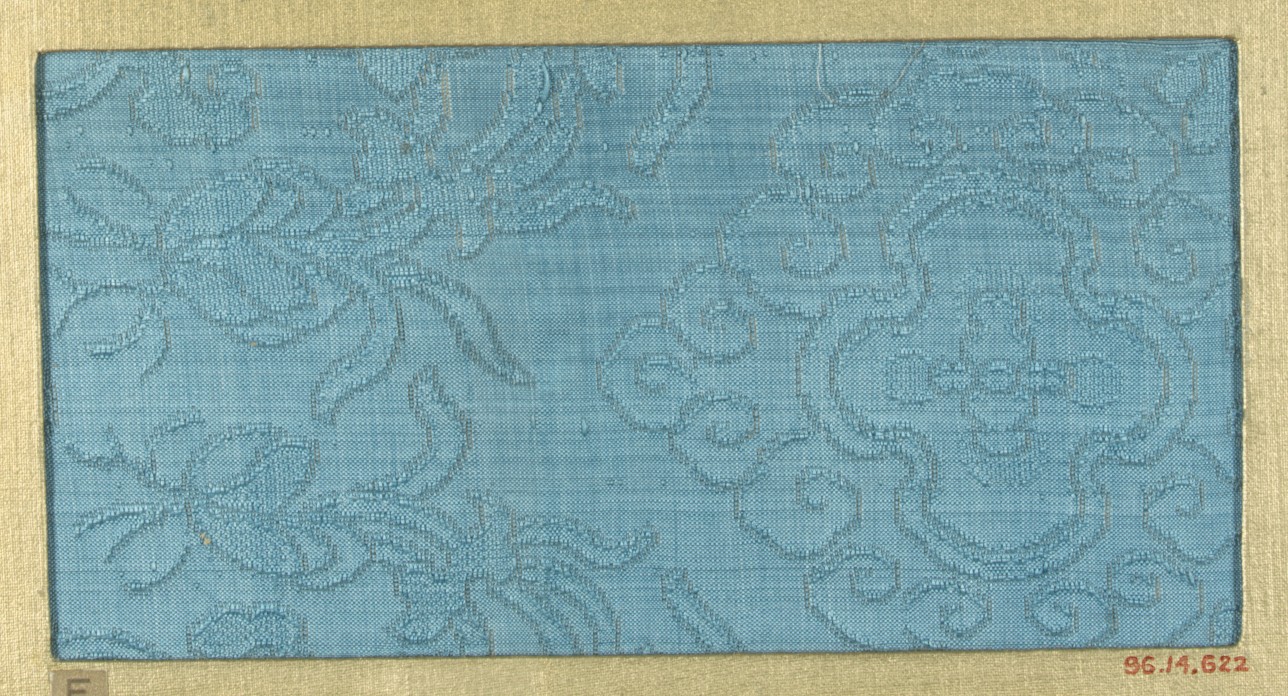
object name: piece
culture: japanese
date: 1701-1900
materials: silk